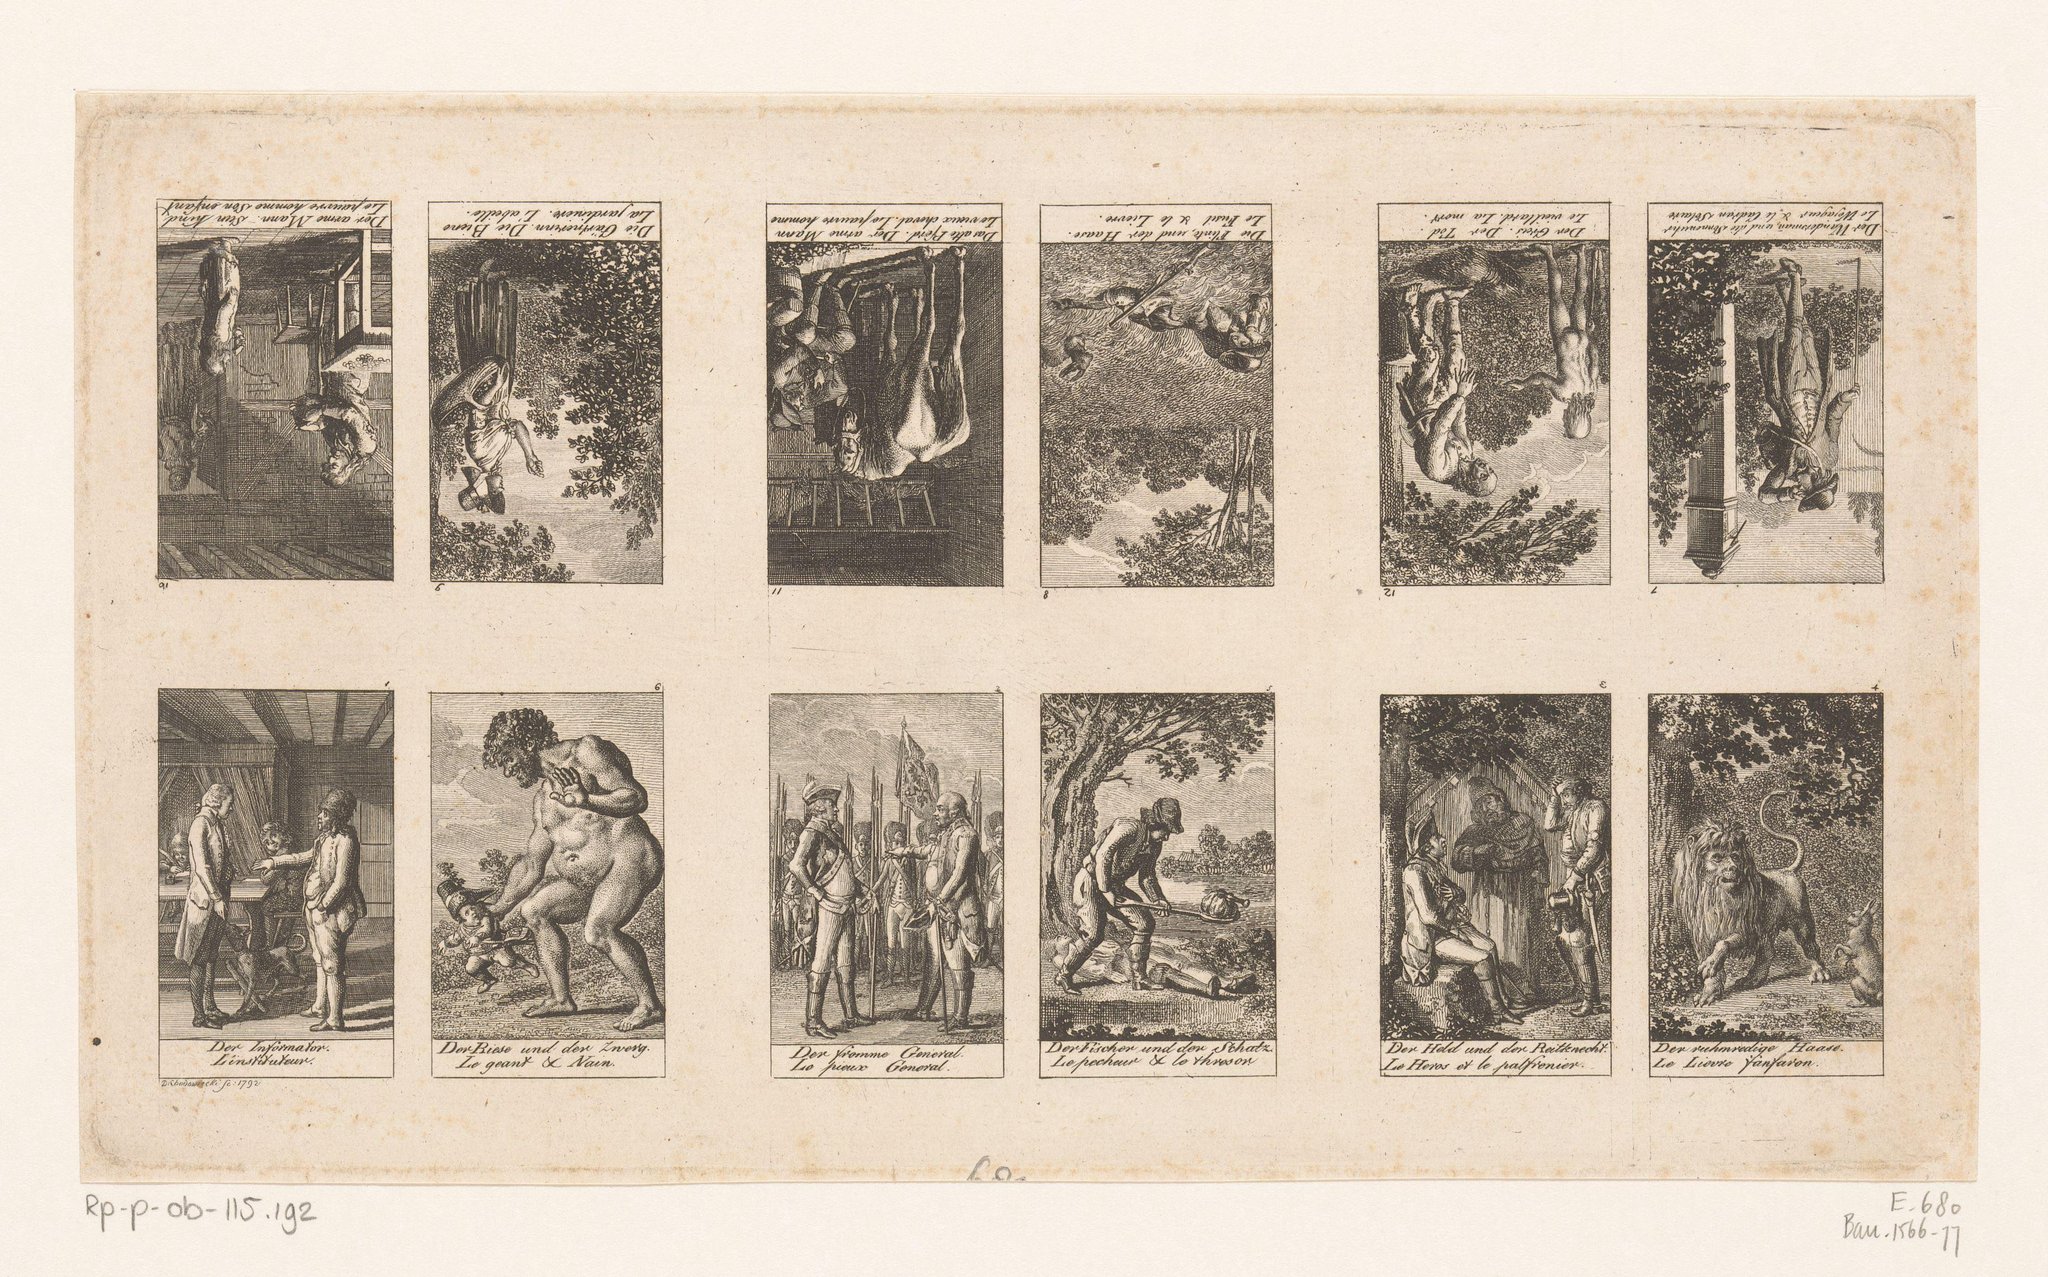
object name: print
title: Twaalf voorstellingen uit de fabels van Gellert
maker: daniel nikolaus chodowiecki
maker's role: draughtsman, print maker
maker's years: 1726-1801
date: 1792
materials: paper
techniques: etching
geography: berlin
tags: literature, hunter, rodents: hare, commander-in-chief, general, marshal, gardening, fables, horse, beasts of prey, predatory animals: lion, sundial, fisherman, digging for or finding of treasure, giants, colossi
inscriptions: collector's mark: Lugt 2228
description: Prent gebruikt voor: Gellert, Christian Fürchtegott. Kleiner Taschen Kalender auf das gemeine Jahr 1795 (...). Berlijn: s.n.s.a.